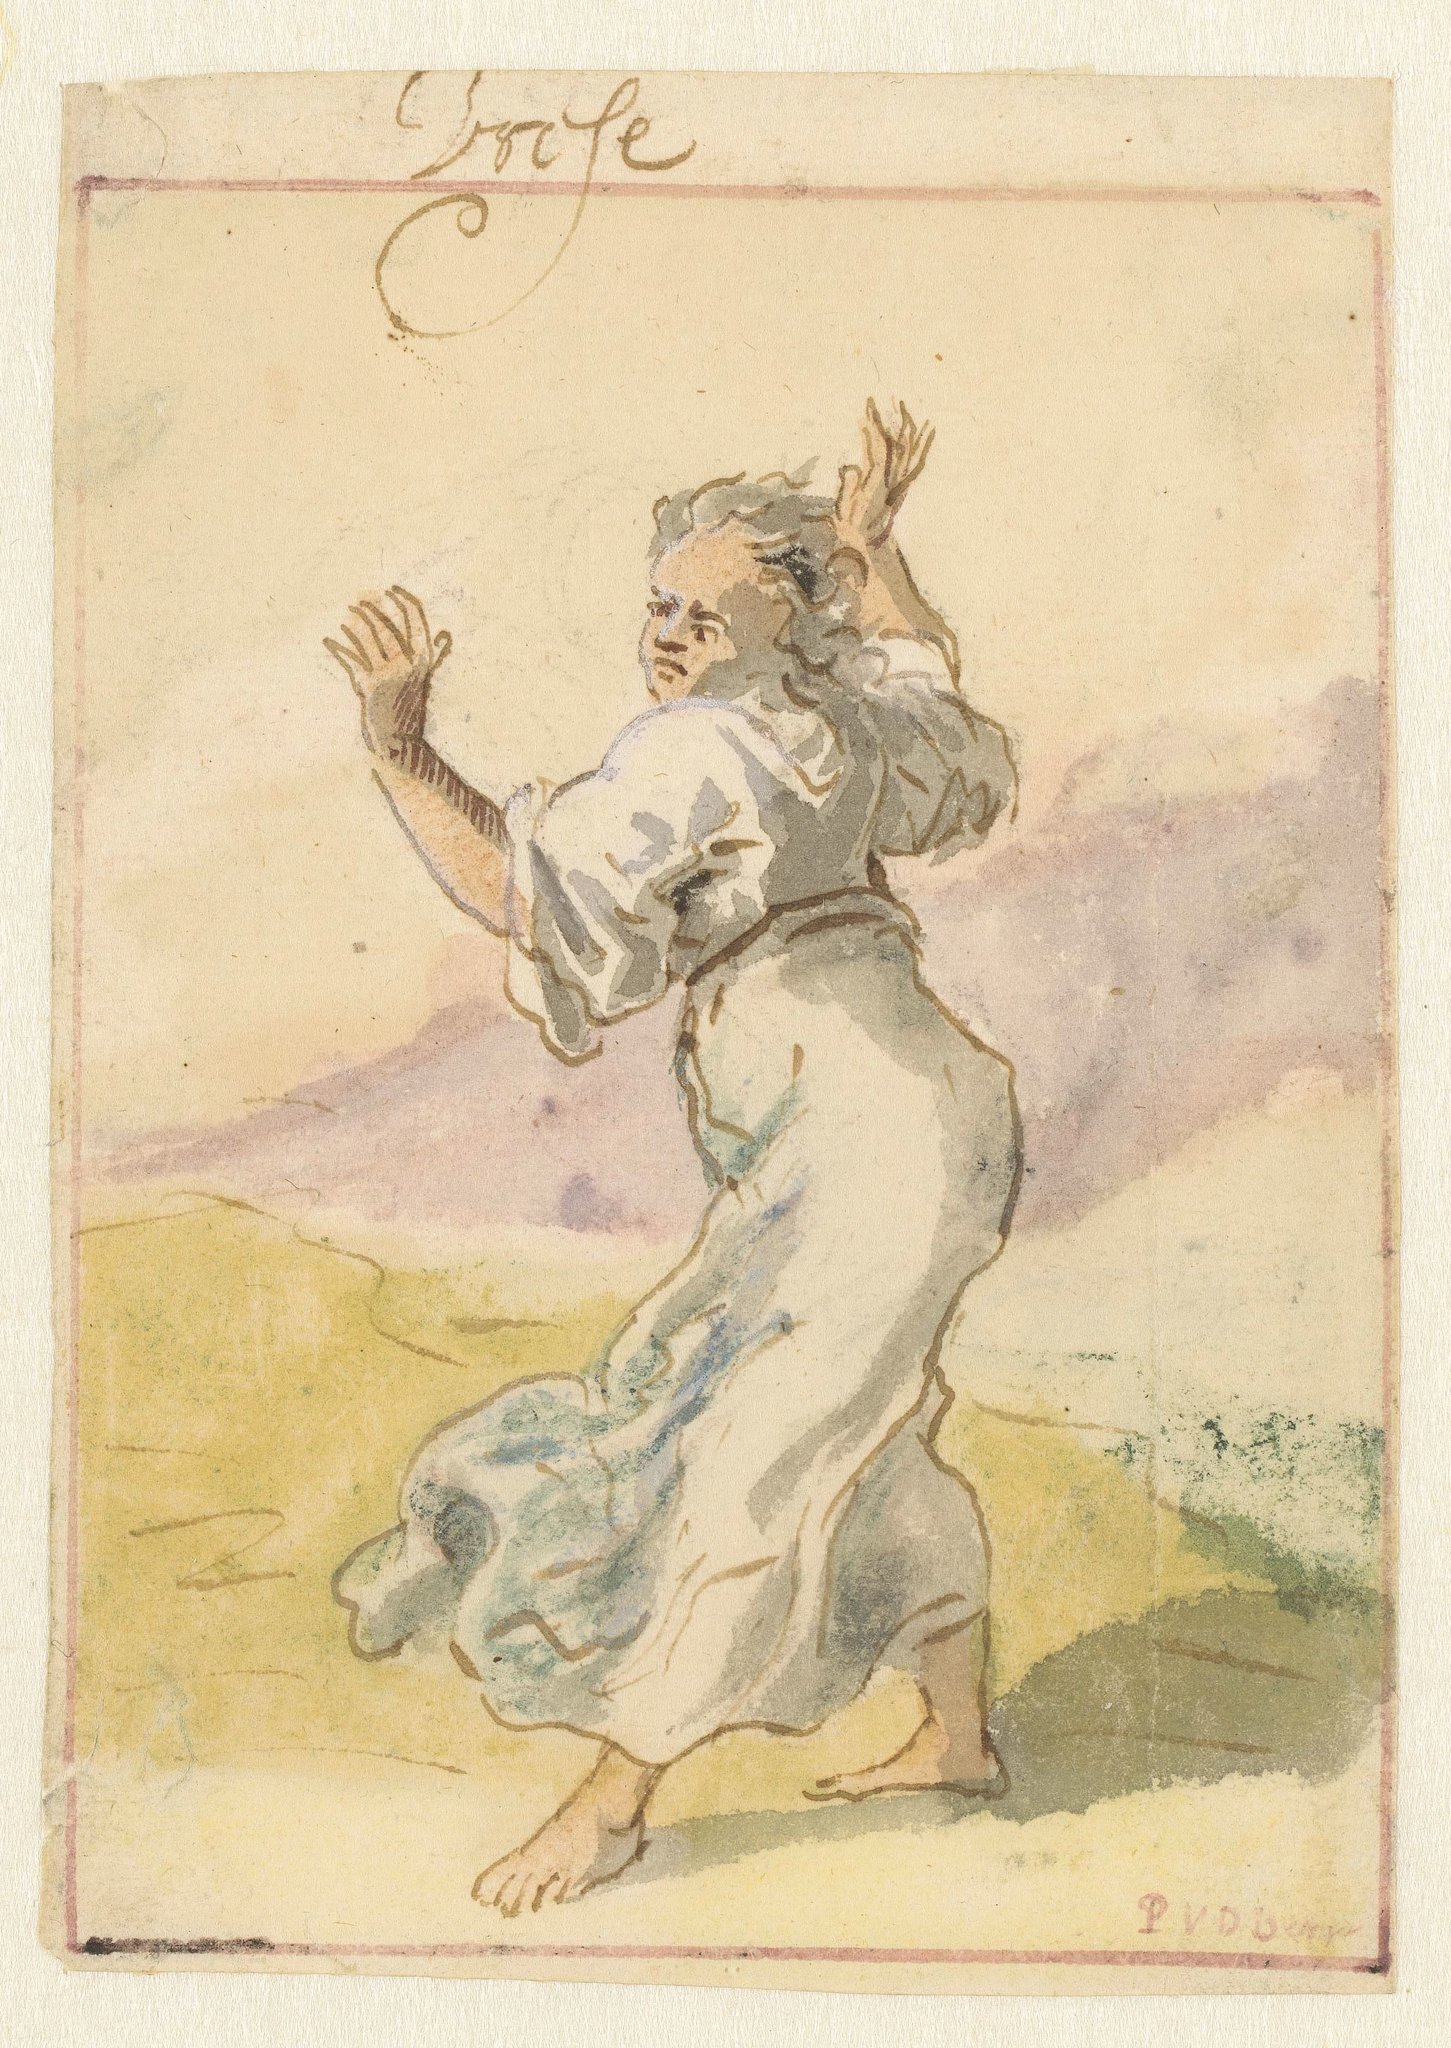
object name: drawing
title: Uitbeeldingen van karakters, eigenschappen, deugden en ondeugden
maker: pieter van den berge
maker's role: draughtsman, print maker, printer, publisher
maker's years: 1659-1737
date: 1675-1737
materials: paint, ink, paper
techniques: brush, pen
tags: fear, dread; 'paura', 'timidità o timore', ímore (ripa) (+ personification)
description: Een staand persoon, links in profiel, de handen opgeheven, het gelaat driekwart naar links.